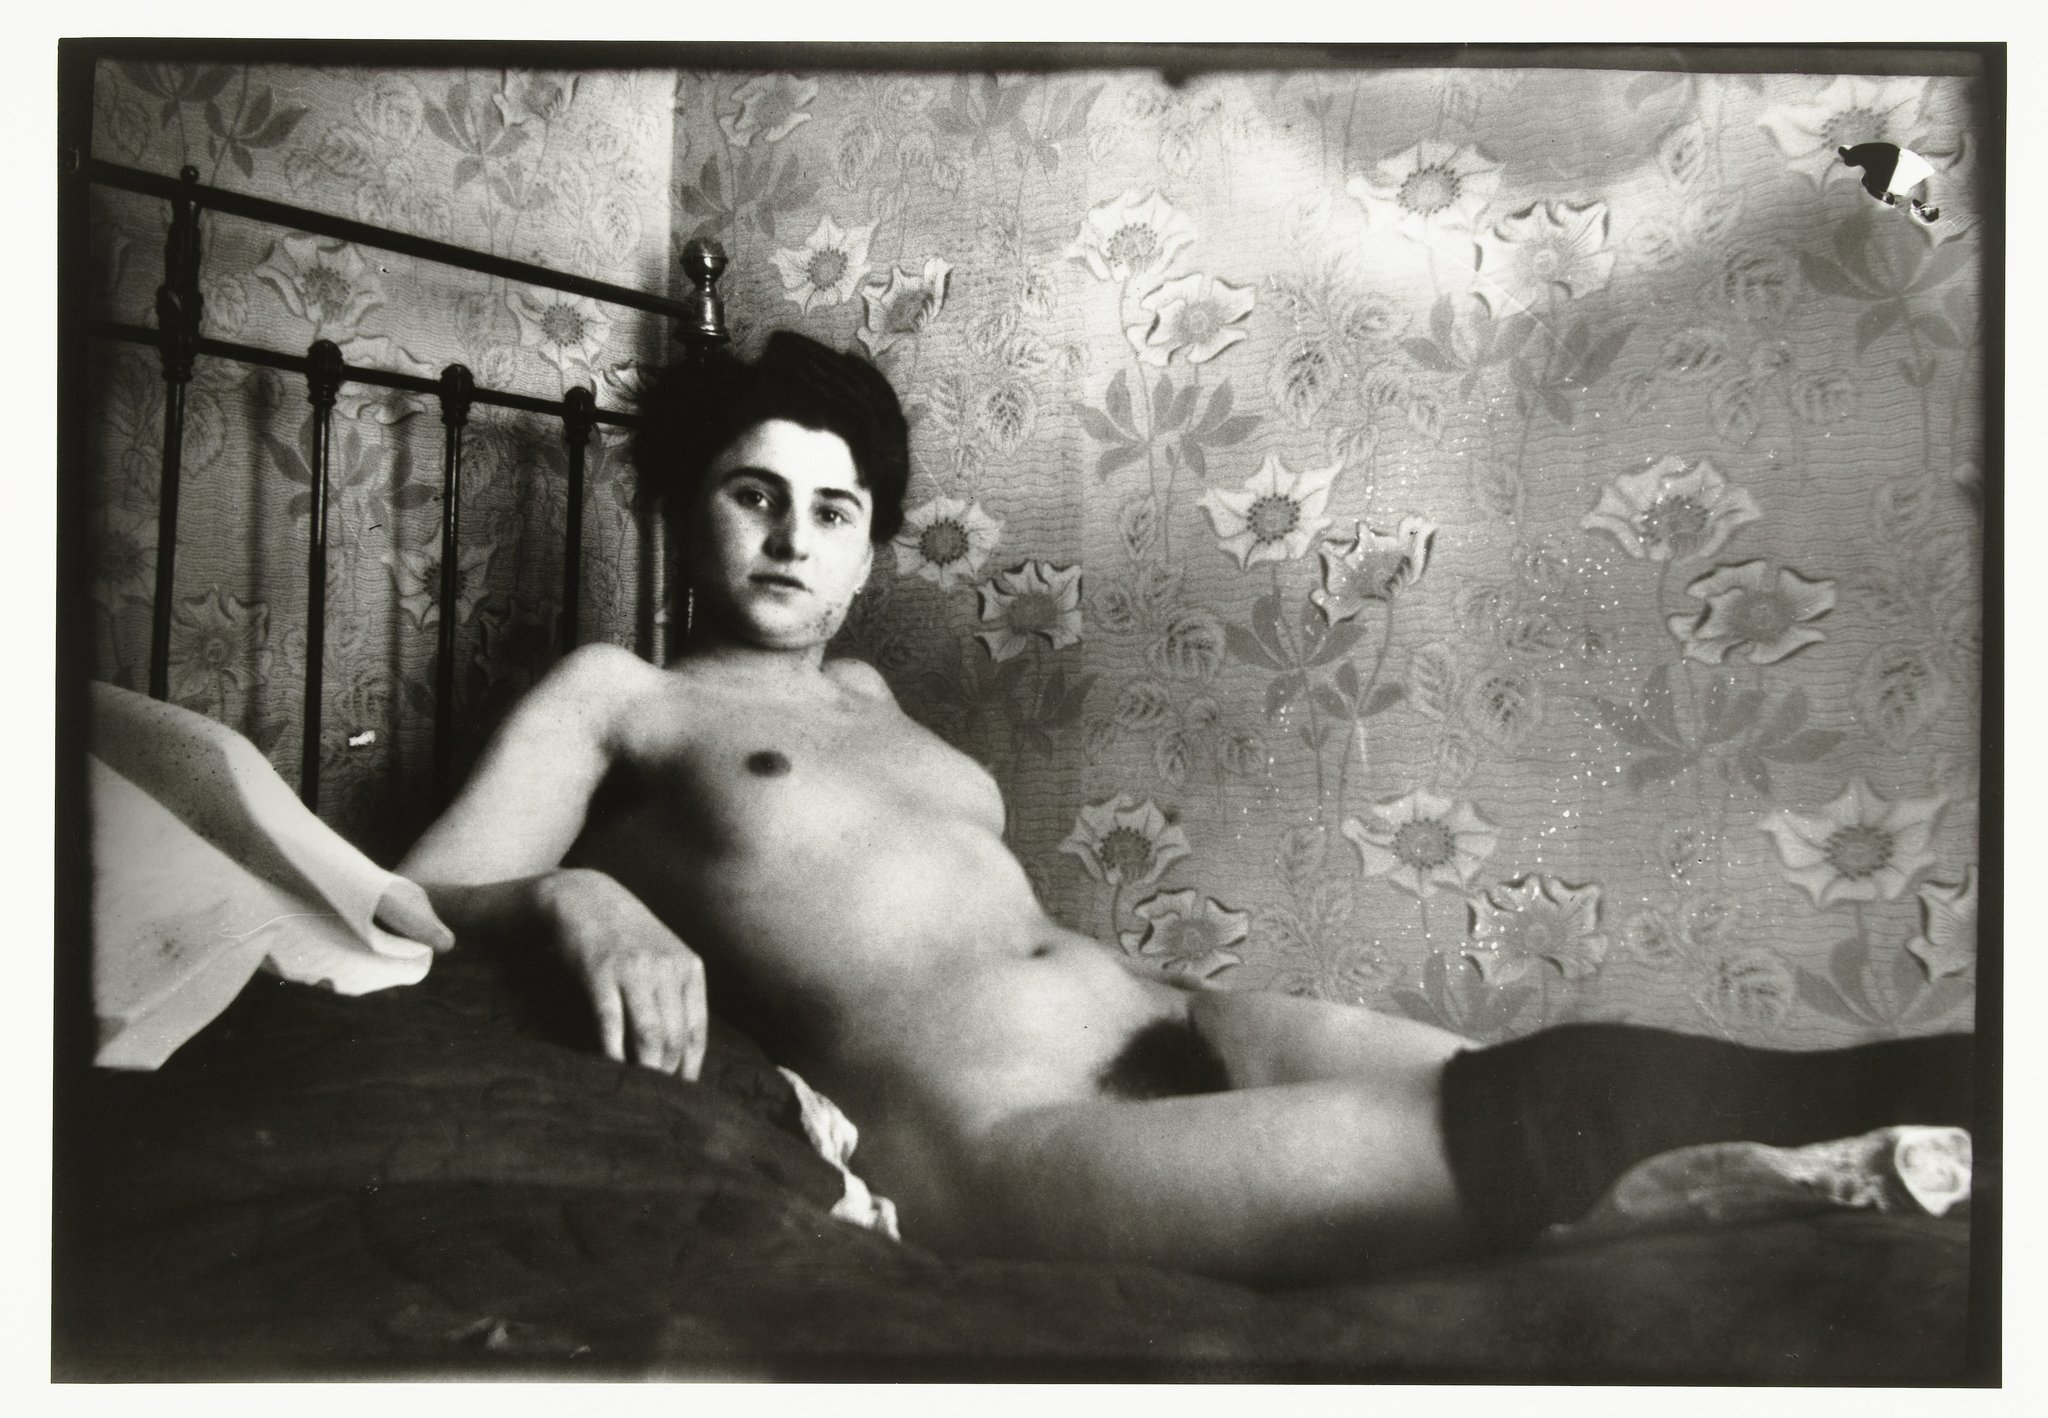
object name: photograph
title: Portret van een liggend vrouwelijk naakt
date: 1890-1910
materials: paper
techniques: gelatin silver print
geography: amsterdam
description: Moderne afdruk van negatief BR 909 (collectie RKD).